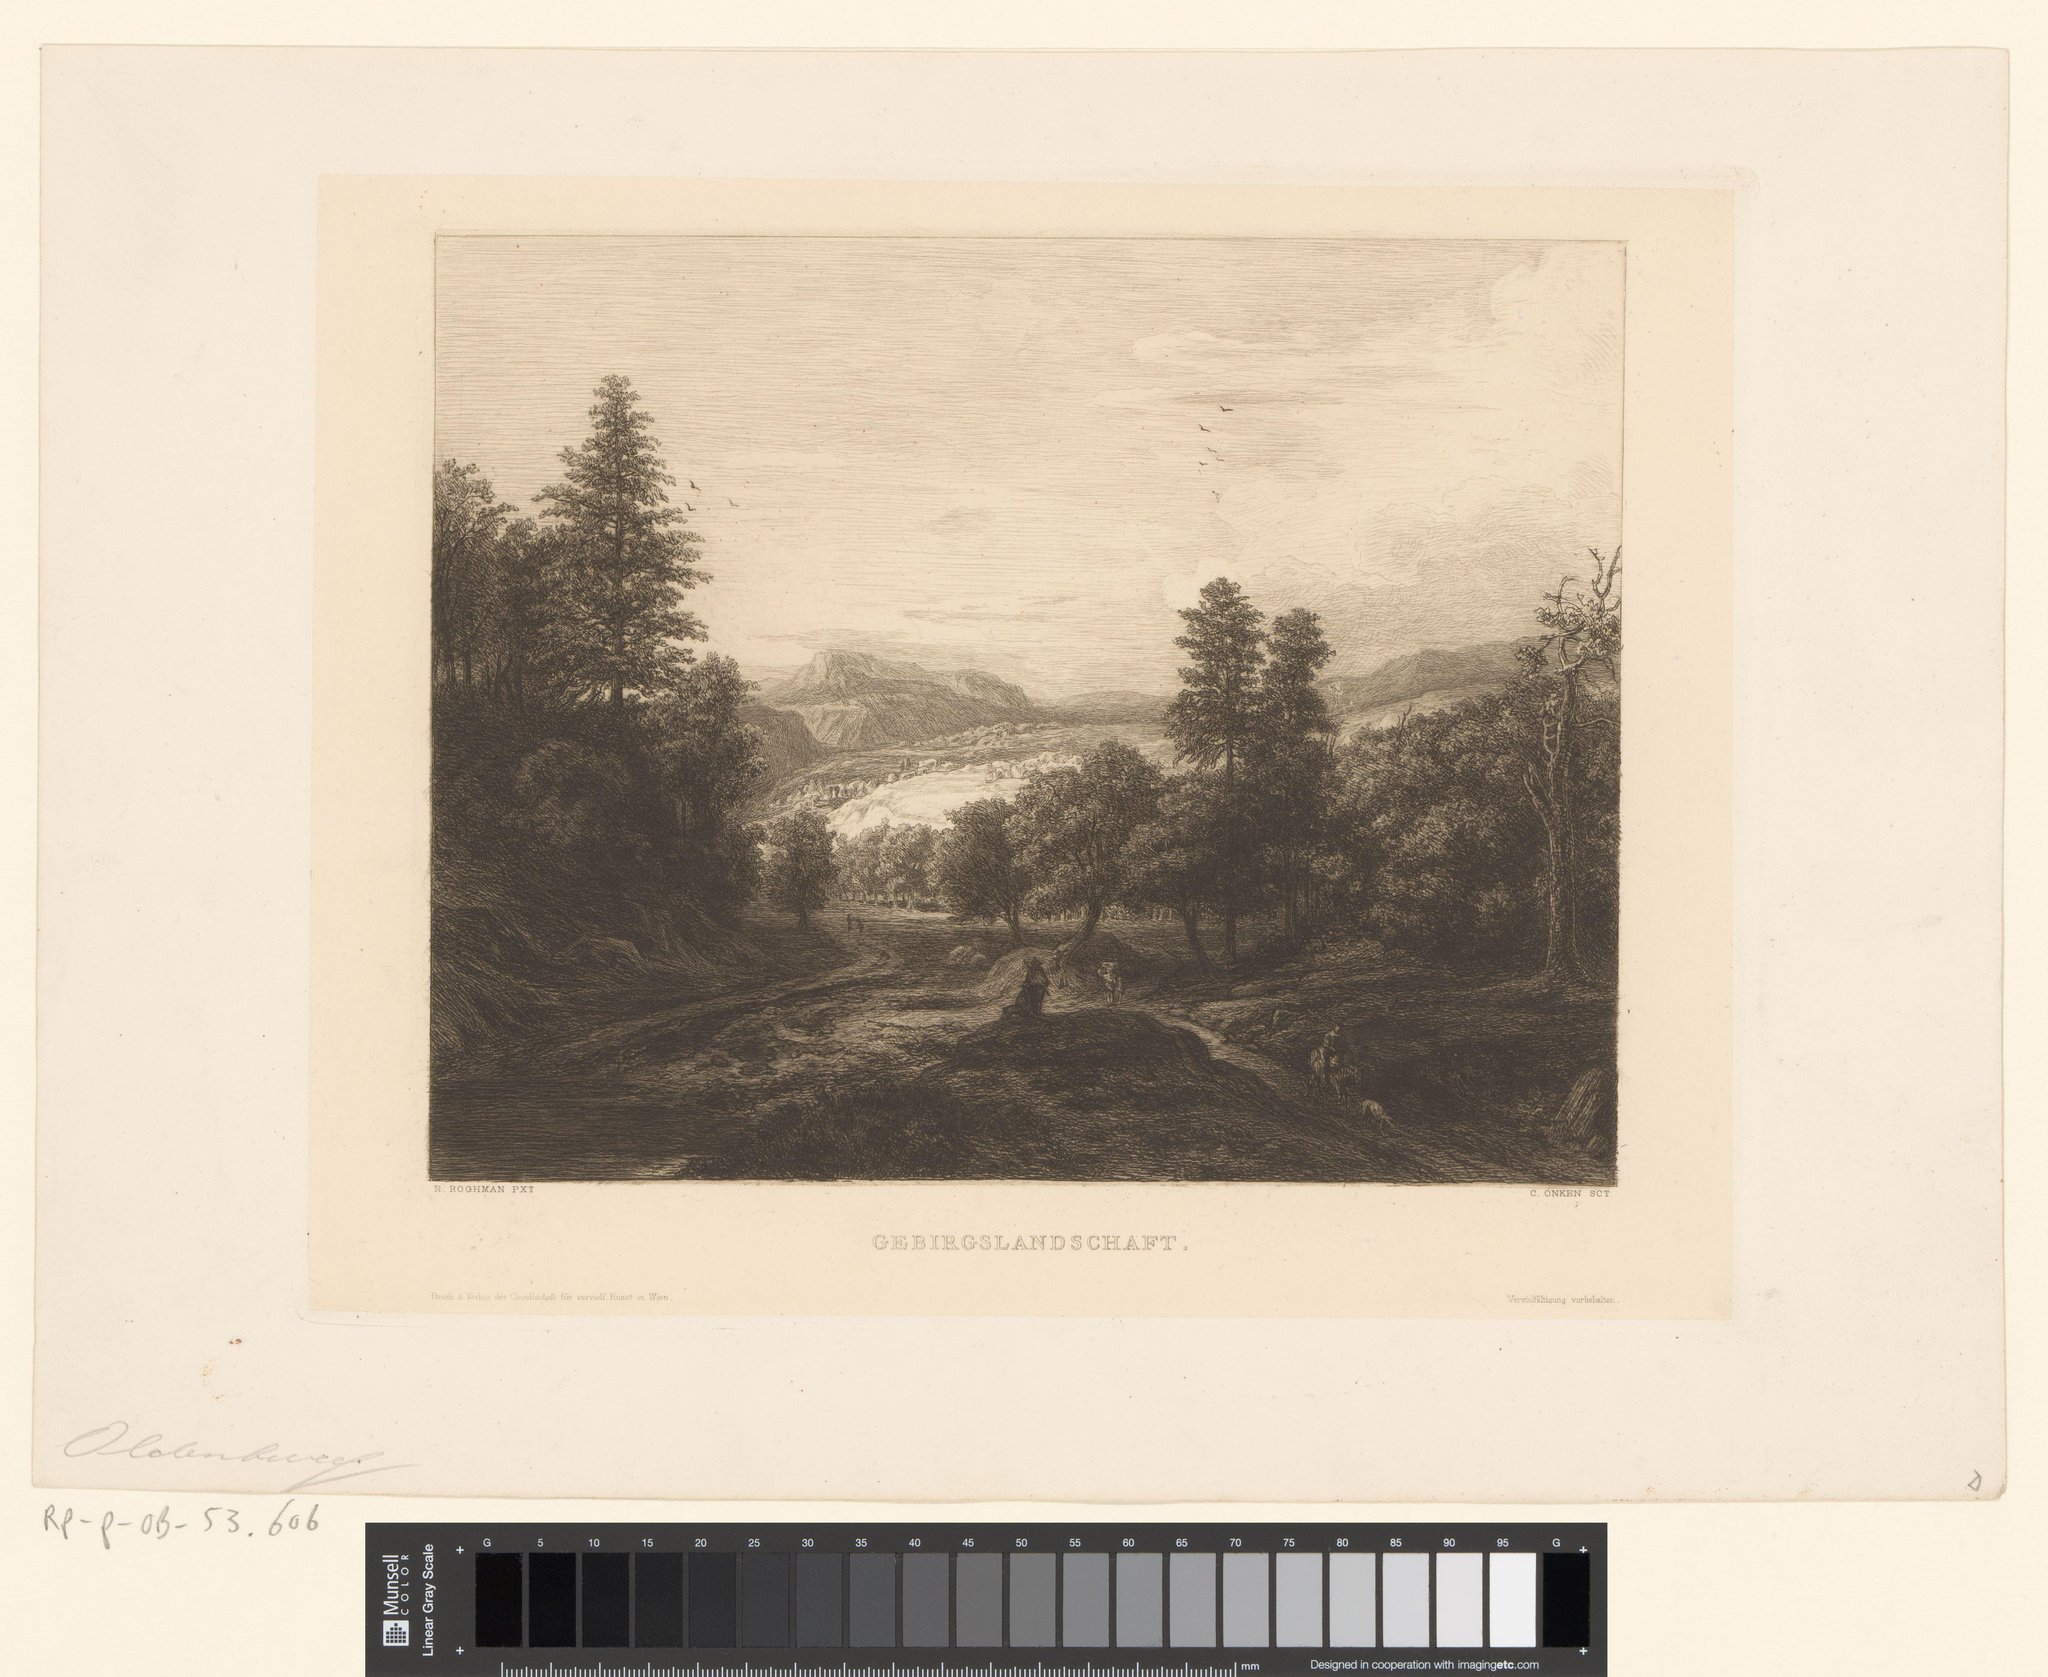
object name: print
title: Gebirglandschaft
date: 1861-1934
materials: paper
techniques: etching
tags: landscapes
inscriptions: name: ‘Oldenburg’